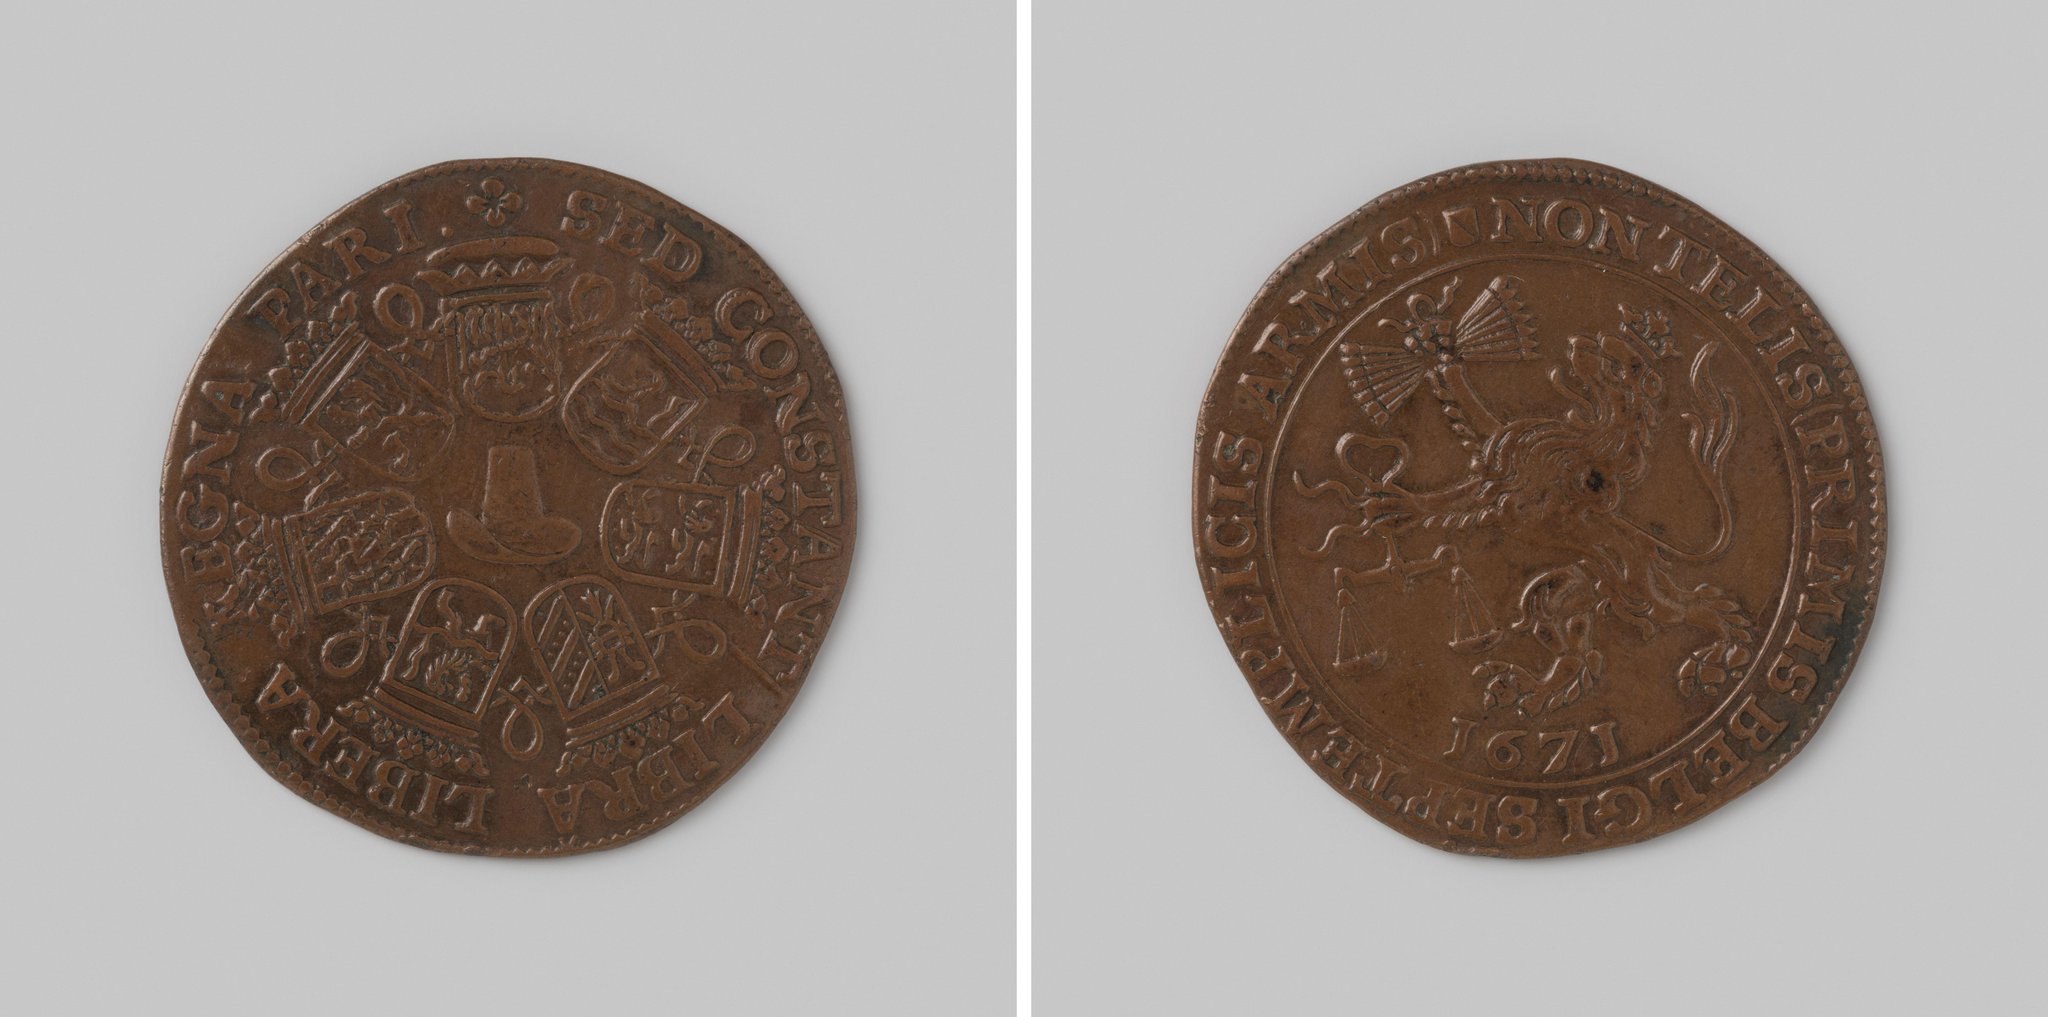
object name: history medal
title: Rekenpenning uit Utrecht op de vredelievendheid van Nederland 1671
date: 1671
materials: copper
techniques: striking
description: Koperen penning, op de voorzijde een vrijheidshoed omringd door zeven gekroonde provinciale wapenschilden verbonden door een lint, met omschrift, op de keerzijde een gekroonde klimmende leeuw naar links met pijlenbundel en weegschaal boven het jaartal, met omschrift.